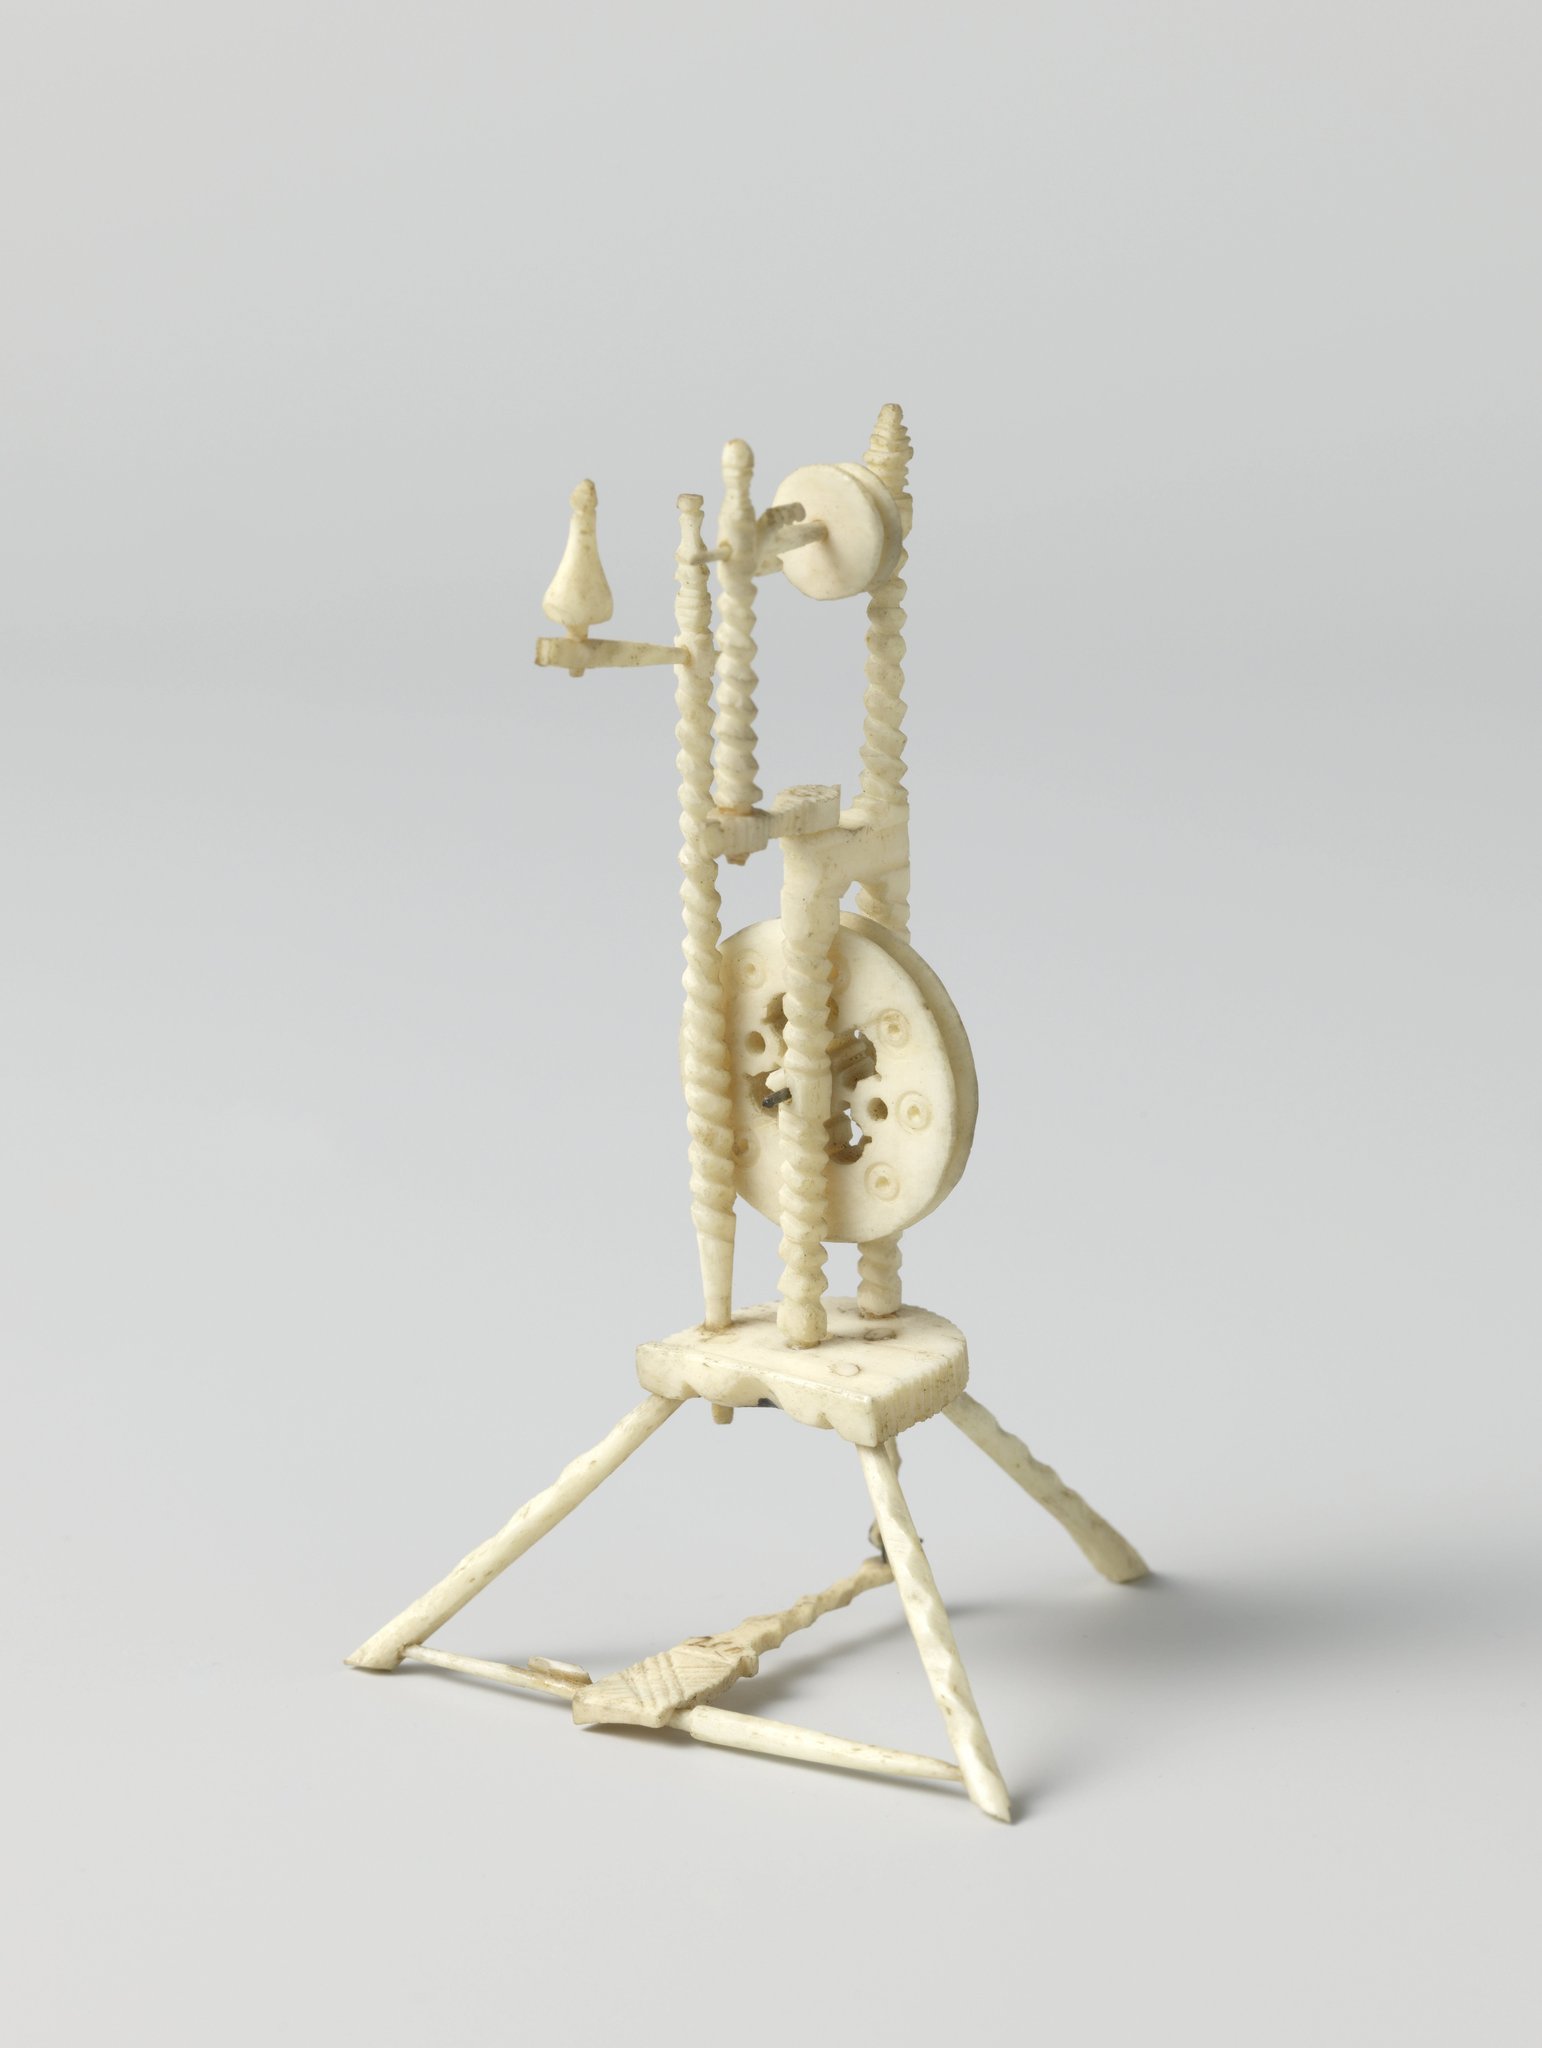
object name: miniature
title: Trapspinnewiel, rechtopstaand model op driepoot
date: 1700-1799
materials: bone, metal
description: Een spinnewiel, rechtopstaand model van gedraaid en met diverse decoratie bewerkt been op driepoot met trappedaal verbonden met metalen slinger van het wiel dat zich in het midden tussen drie gedraaide stijlen bevindt; boven, bevestigd aan deze stijlen de spoel of spindel met vleugel en het spinrokken.